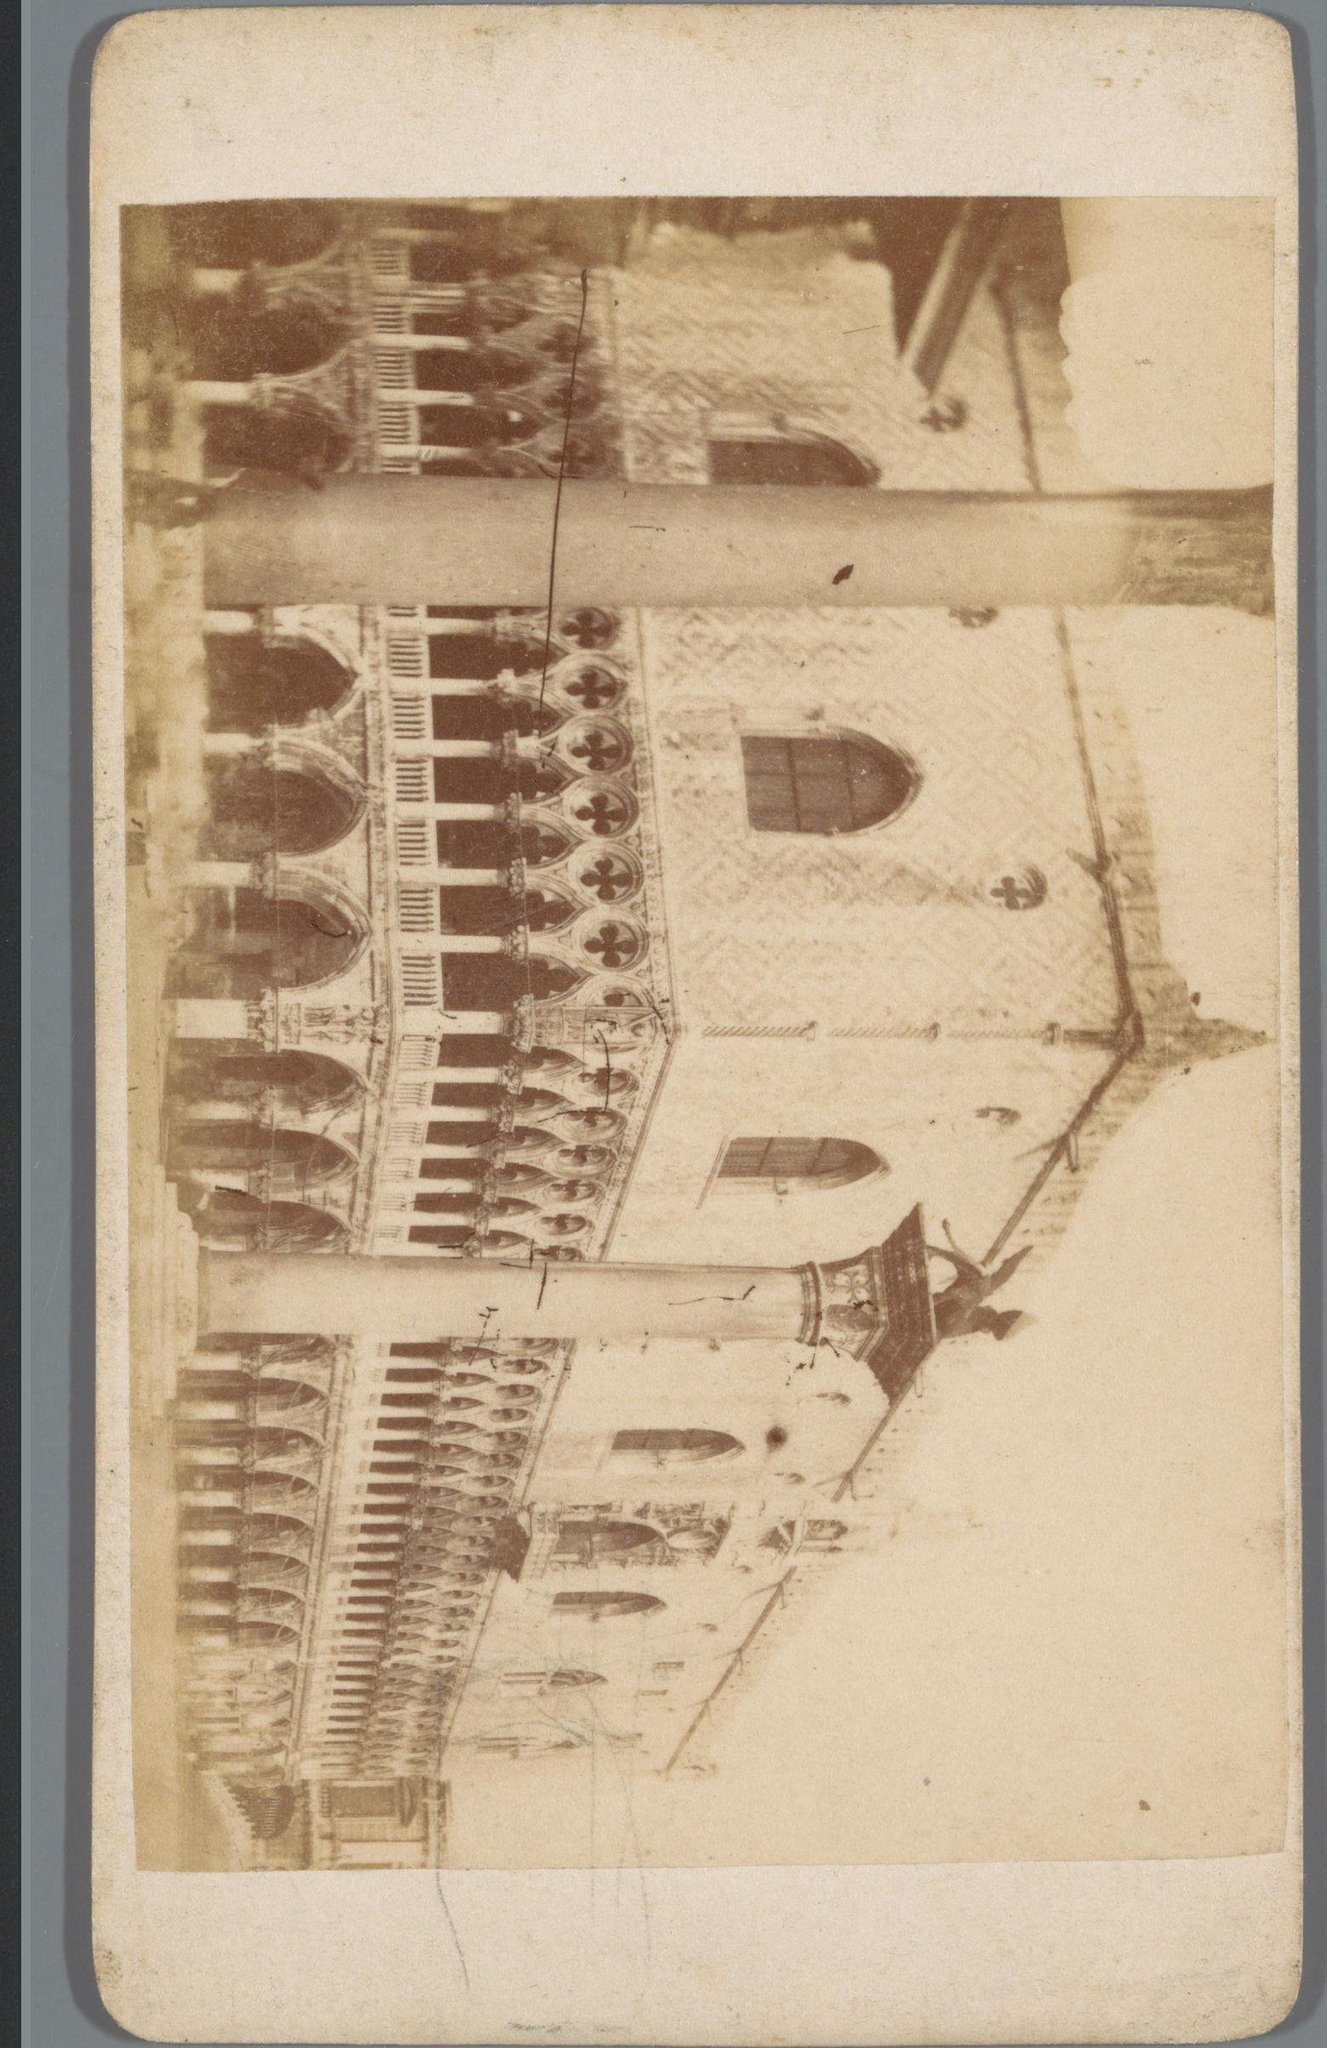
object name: carte de visite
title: Dogepaleis, Venetië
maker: Anonymous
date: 1855-1885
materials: cardboard, paper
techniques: albumen print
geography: venice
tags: palace